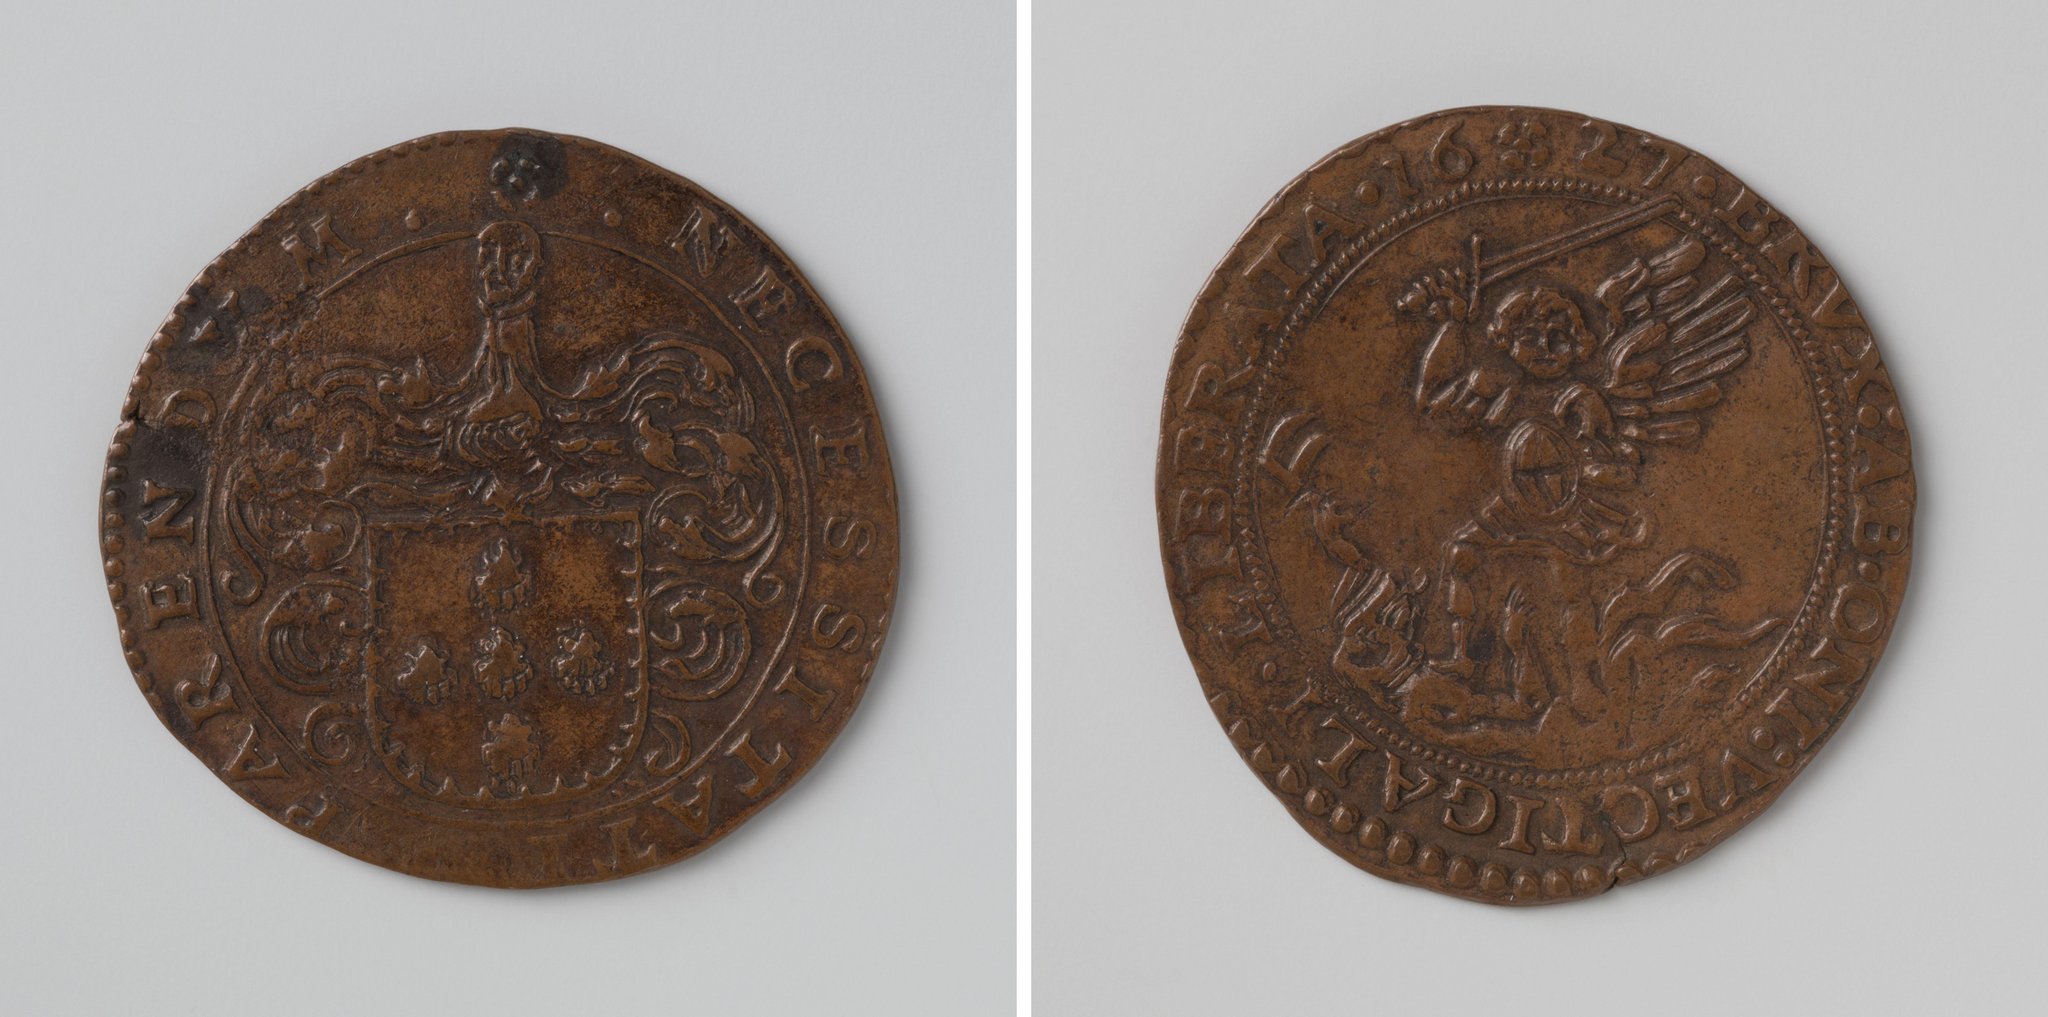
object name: jeton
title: Stad Brussel, rekenpenning geslagen ter ere van Van der Noot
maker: Anonymous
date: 1627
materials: copper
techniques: striking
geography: belgium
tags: brussels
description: Koperen penning. Voorzijde: gehelmd wapenschild binnen omschrift. Keerzijde: aartsengel Michael met zwaard boven hoofd geheven in gevecht met ter aarde liggende draak binnen omschrift